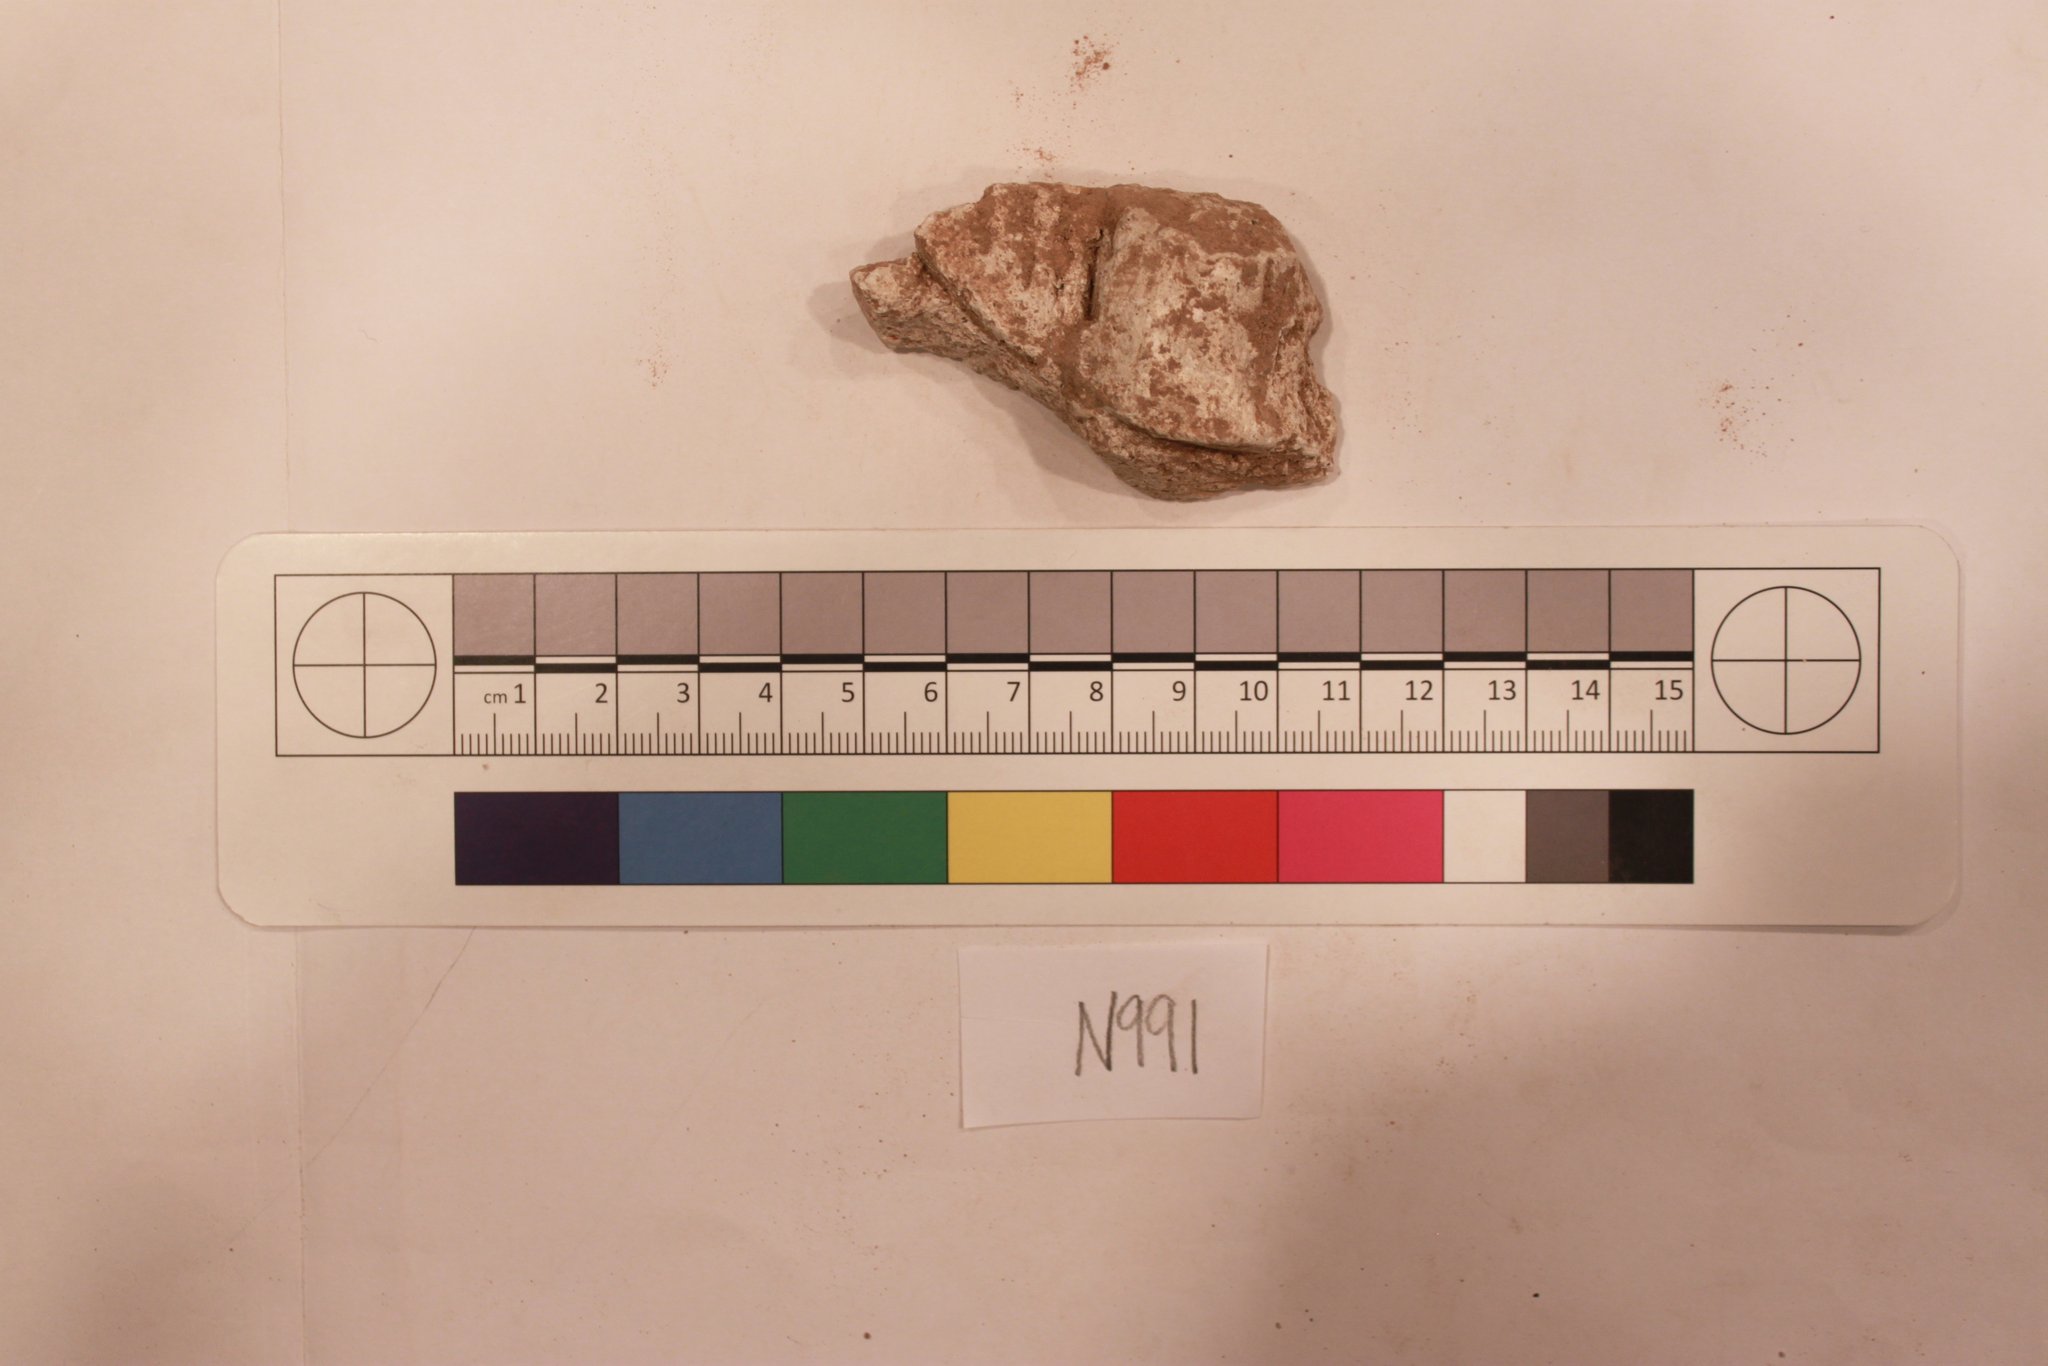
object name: fragment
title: Stucco Fragment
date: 701-1200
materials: plaster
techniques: carving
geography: iran